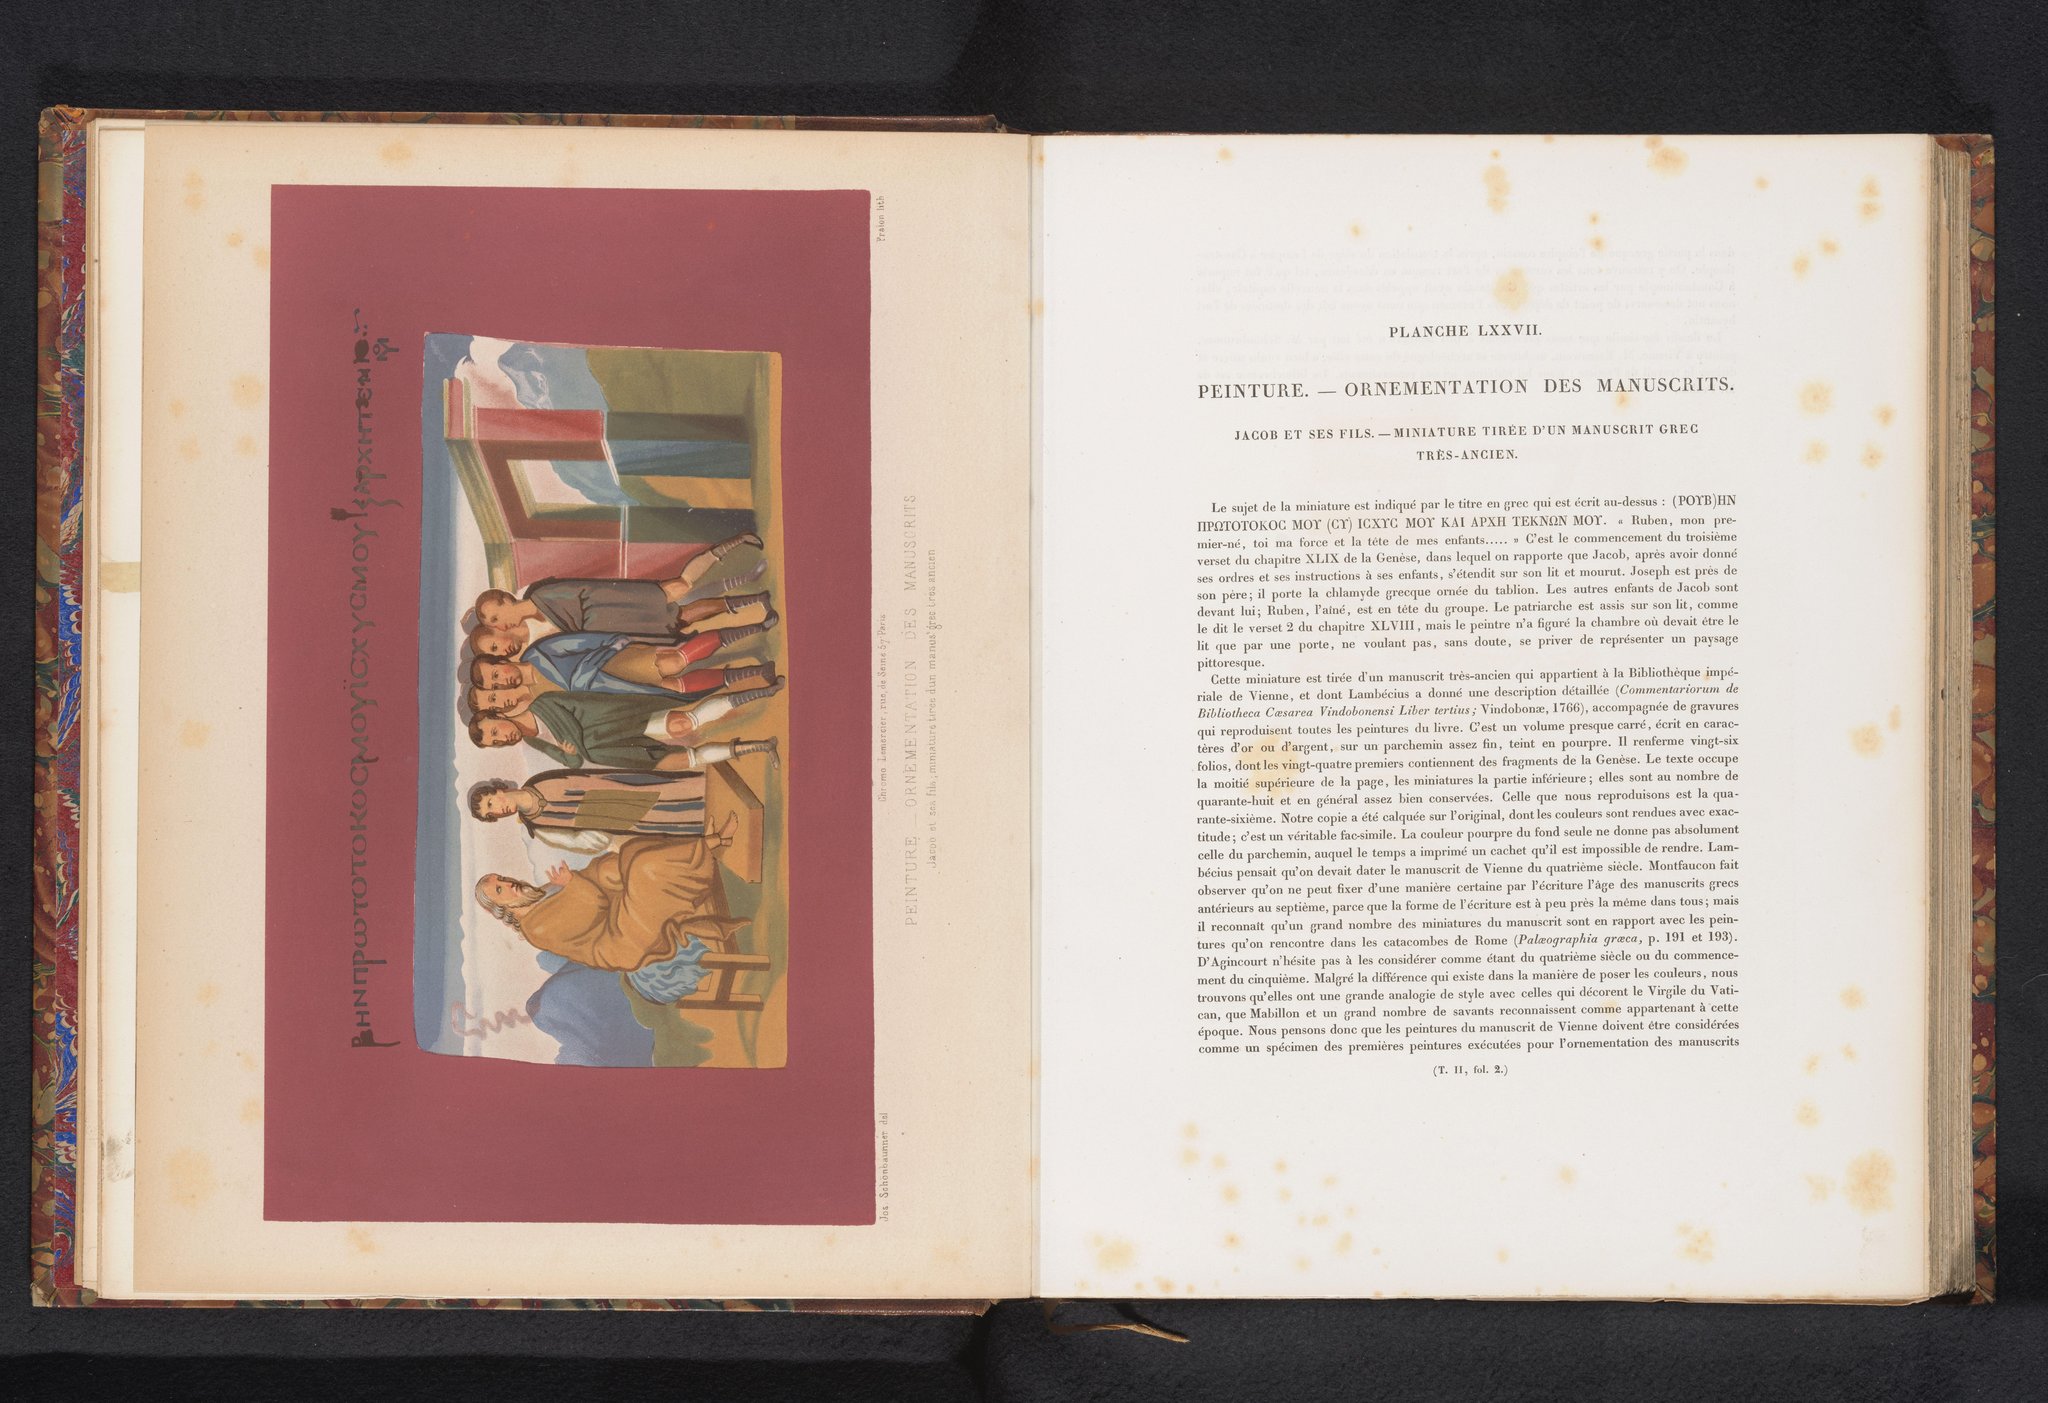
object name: print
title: Jaob et ses fils, miniature tiree d'un manus grec très ancien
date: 1859-1864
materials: paper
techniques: chromolithography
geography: paris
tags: story of jacob, painting, drawing and the graphic arts